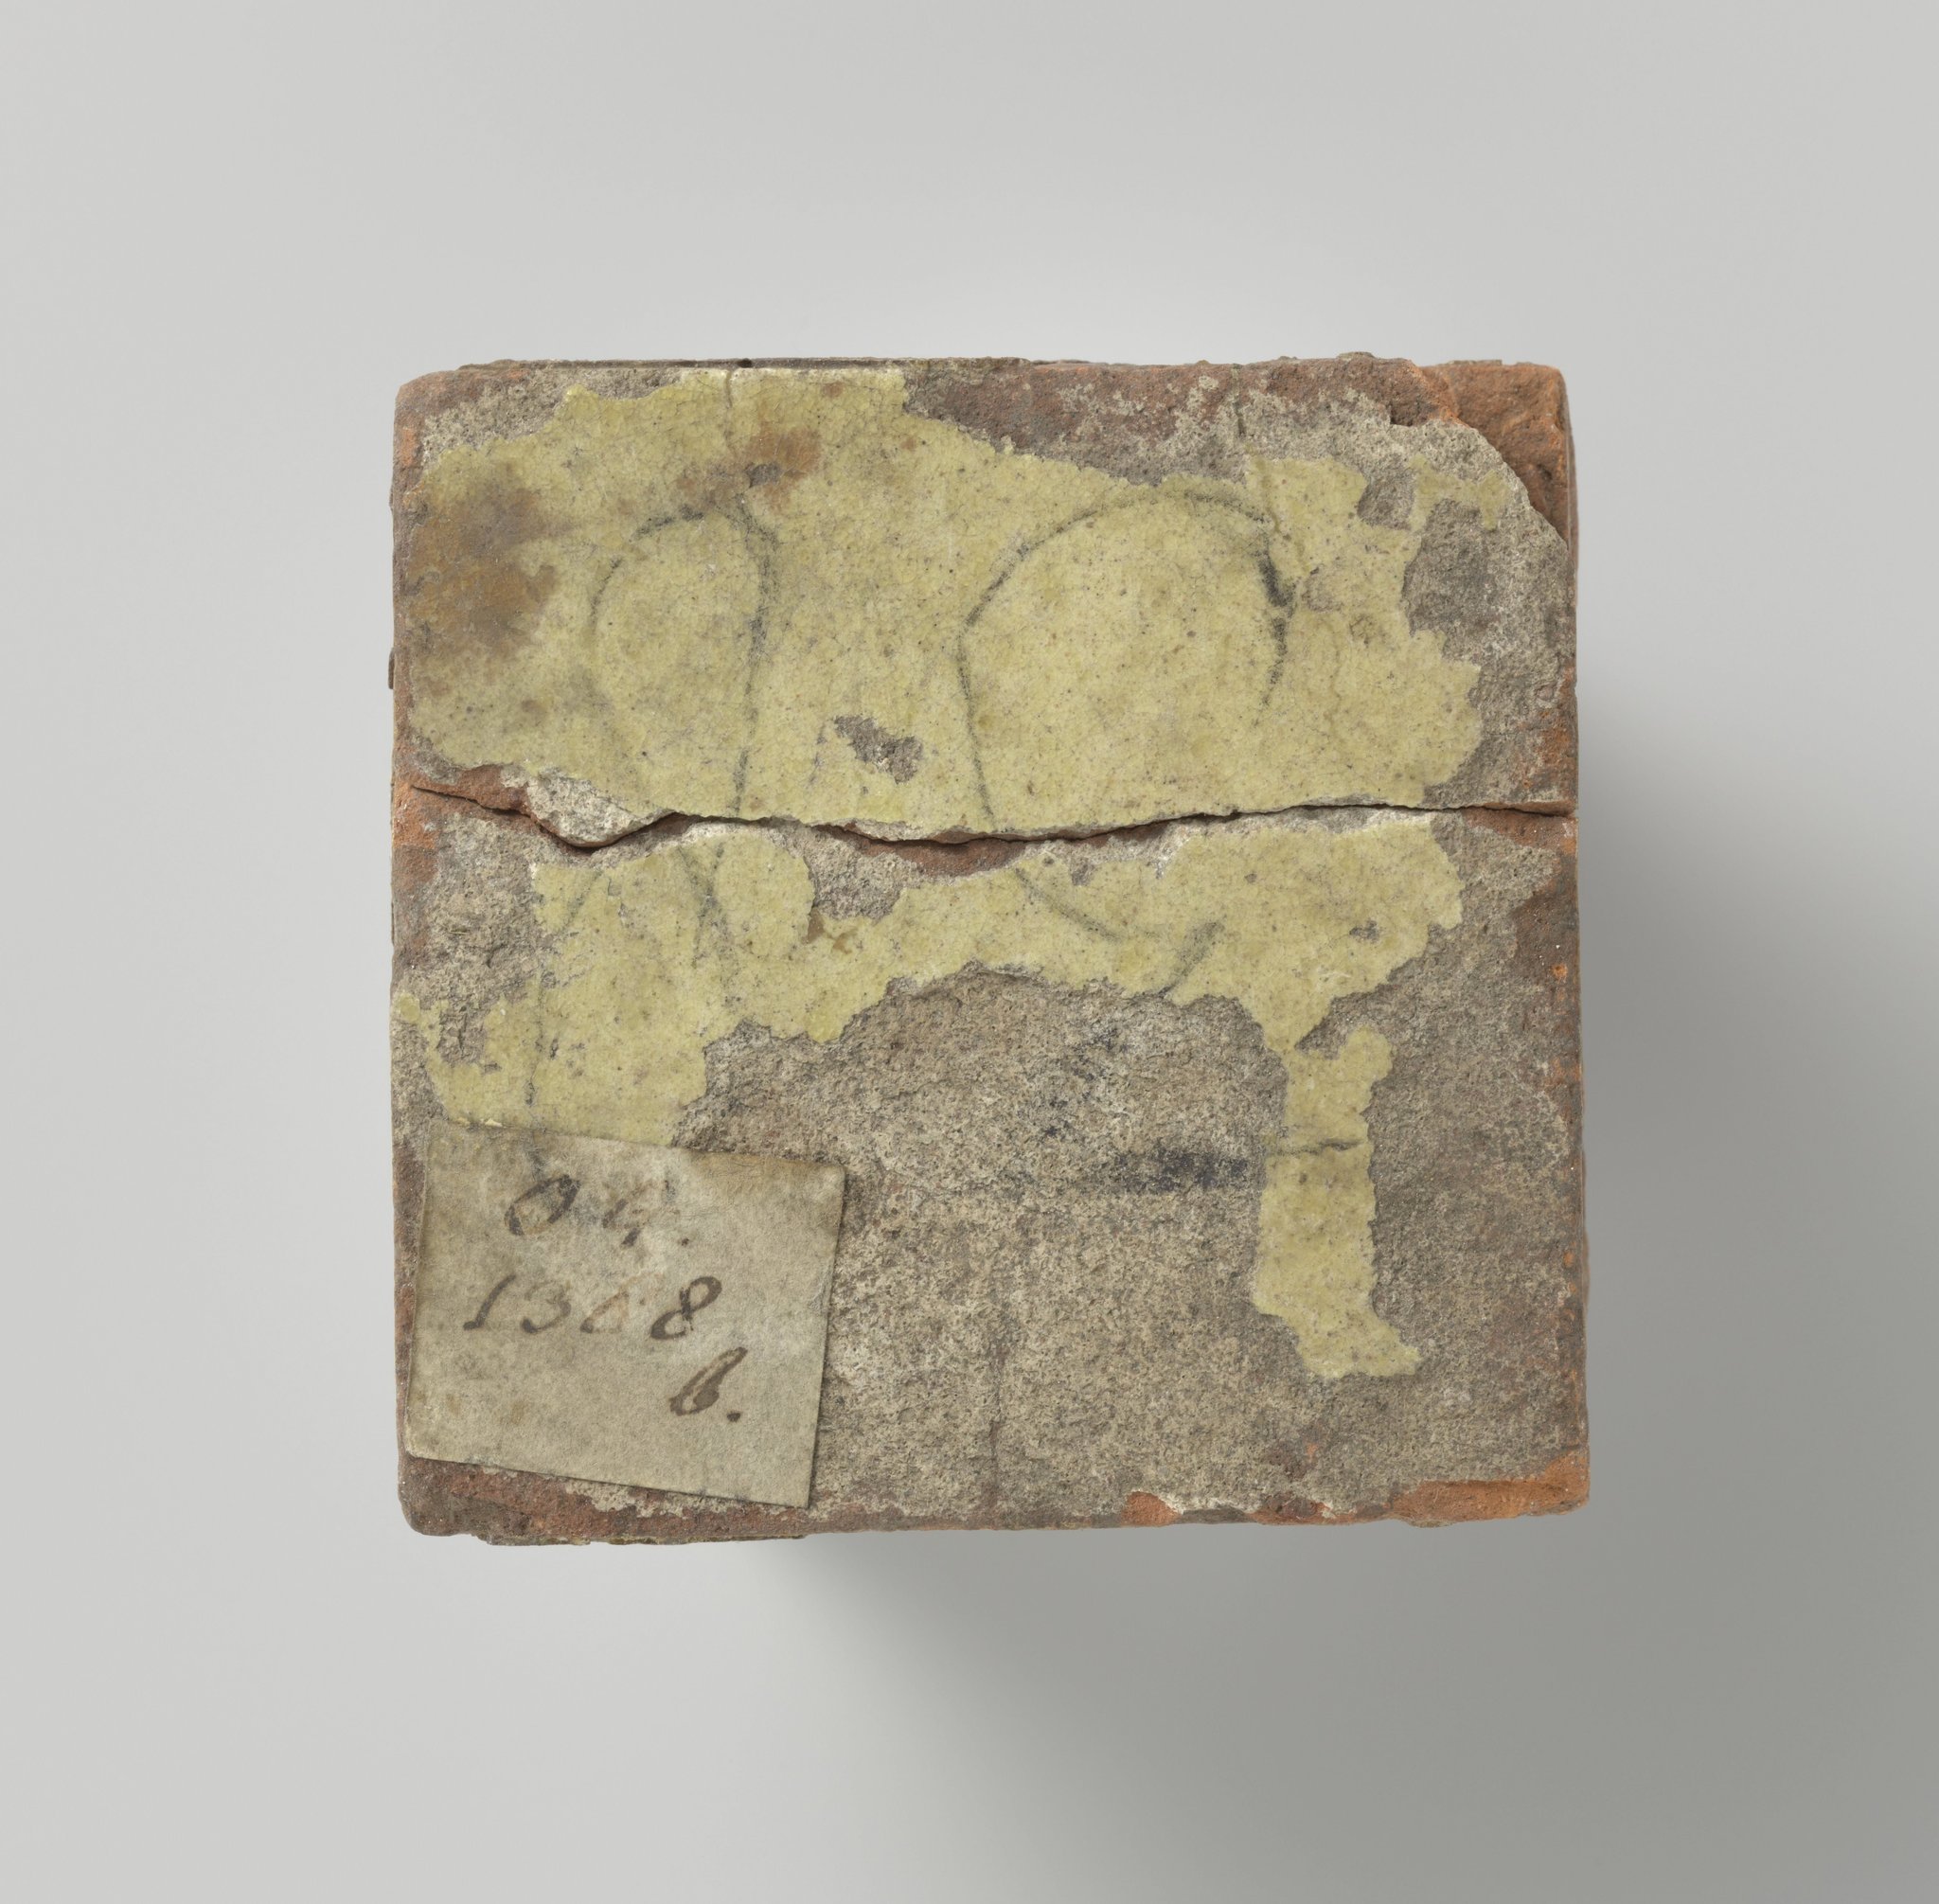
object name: floor tile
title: Geel geglazuurde vloertegel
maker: Anonymous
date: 1400-1600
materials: earthenware, glaze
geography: netherlands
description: Geel geglazuurde vloertegel van roodbakkend aardewerk. De tegel hoort bij drie vloertegels (BK-NM-1388-1 t/m BK-NM-1388-4).